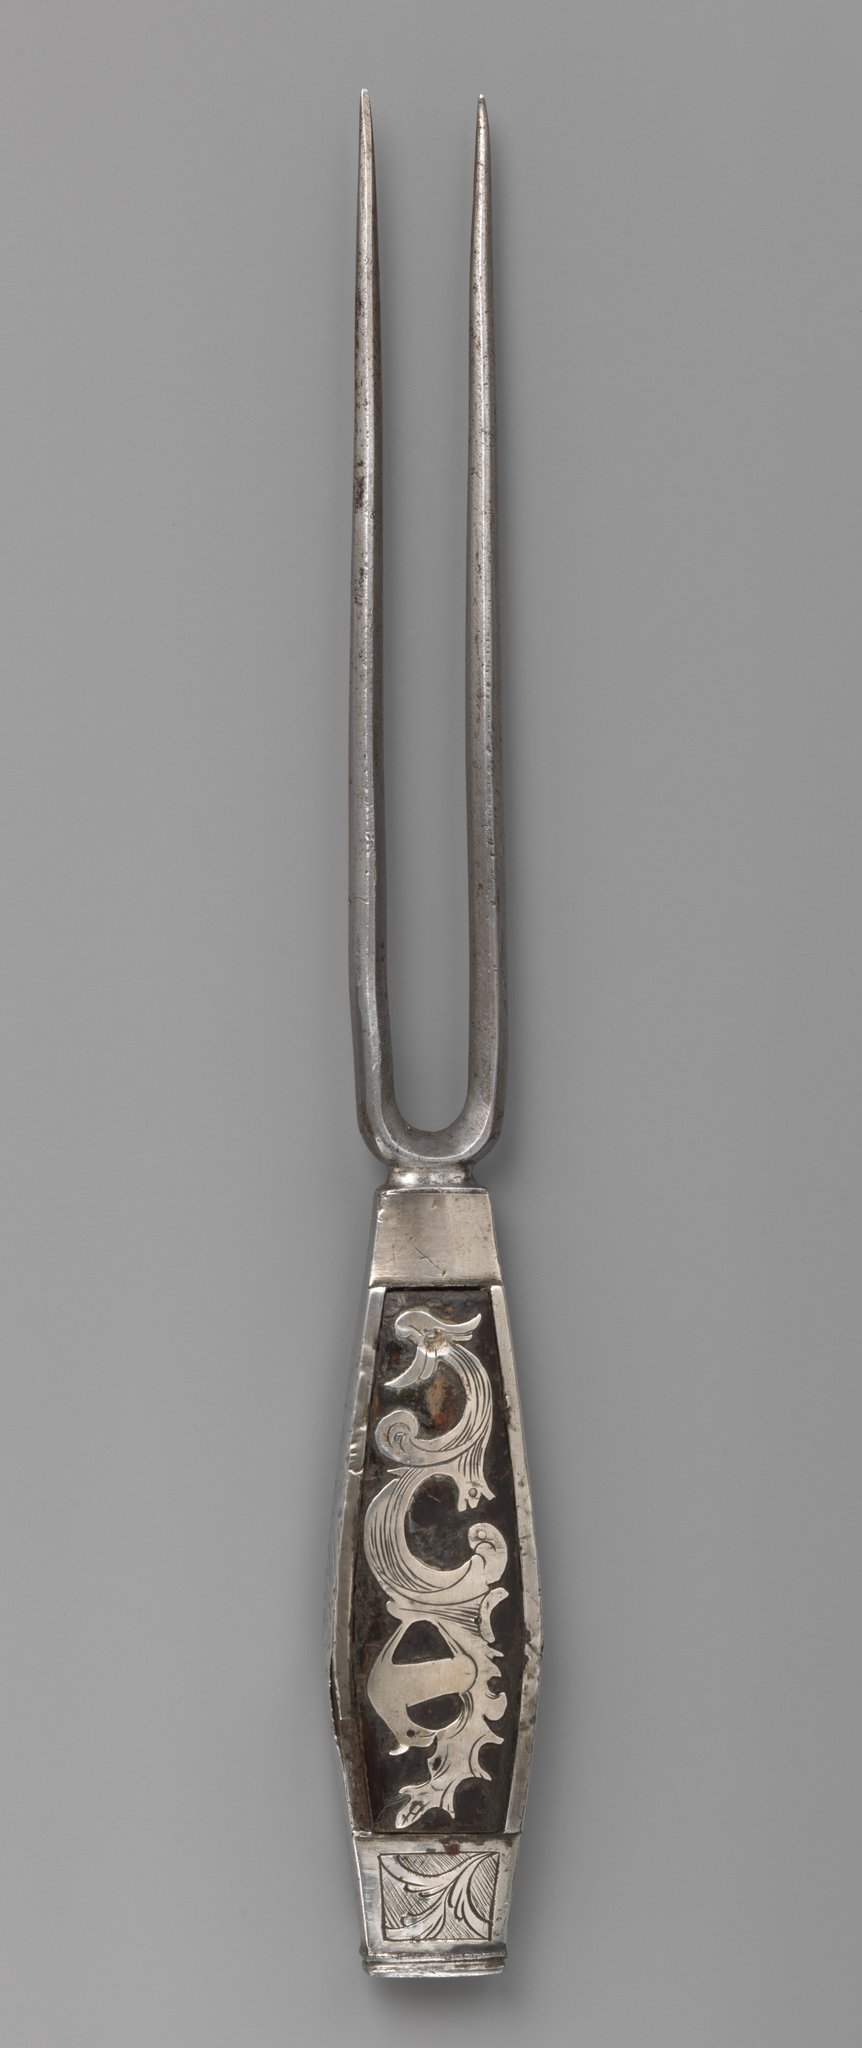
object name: fork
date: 1701-1800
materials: leather, silver, steel, wood